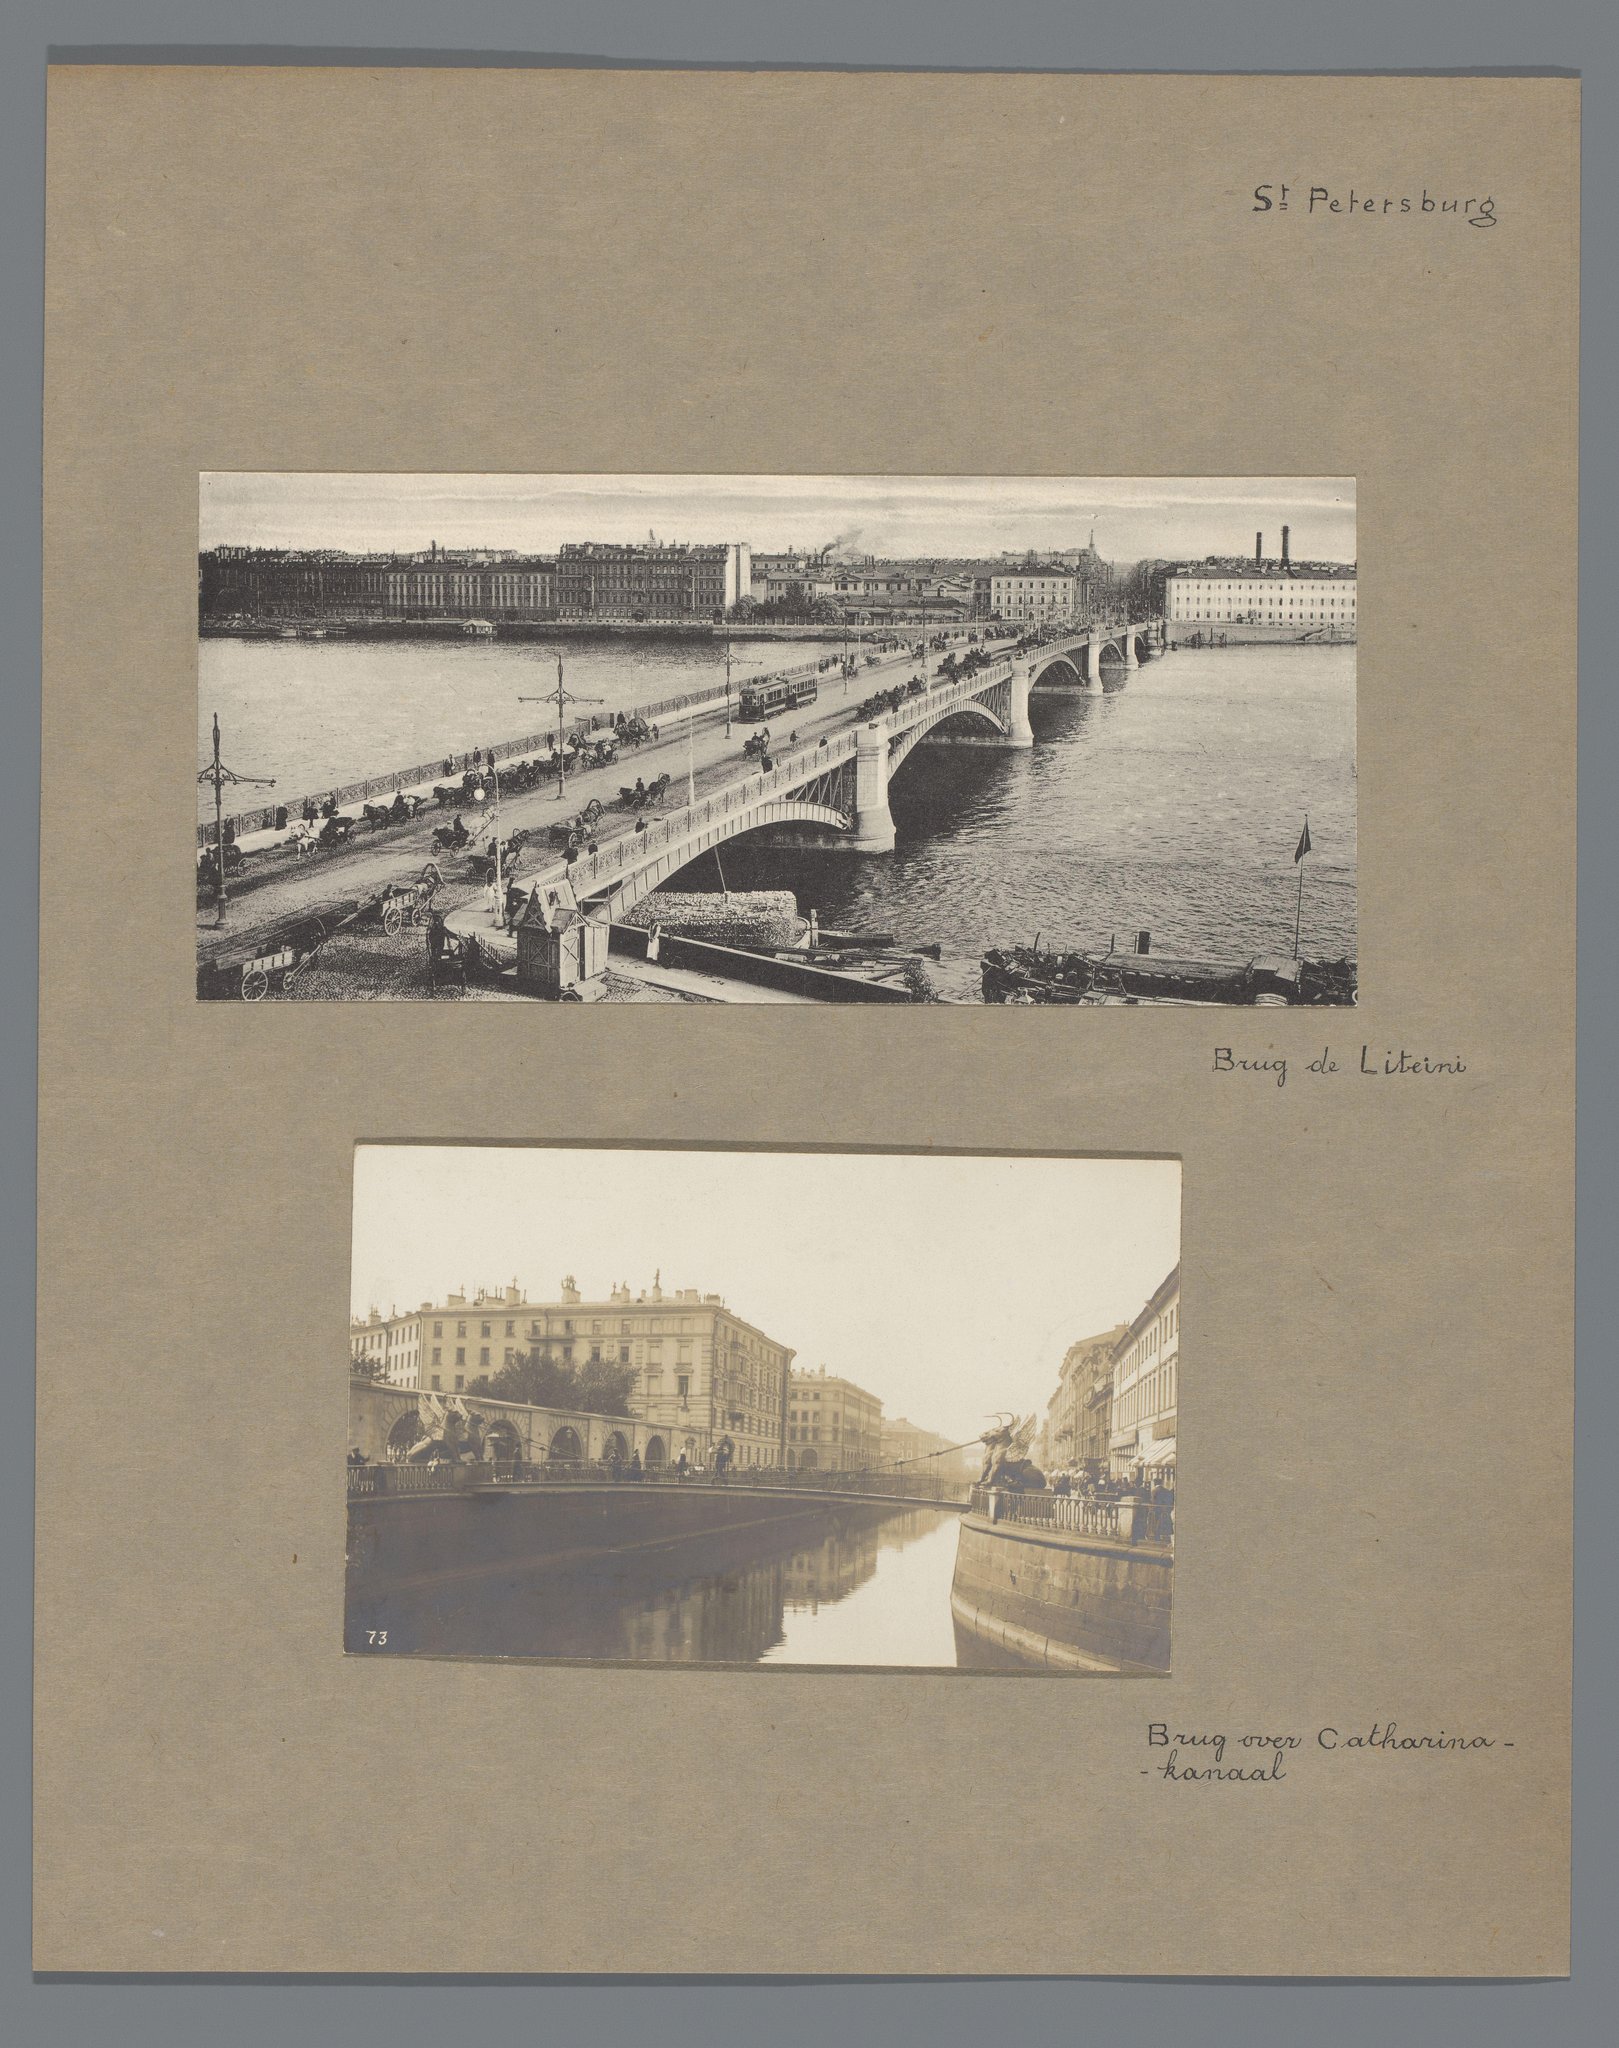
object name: photograph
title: St. Petersburg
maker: Anonymous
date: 1860-1925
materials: photographic support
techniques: photograph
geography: russia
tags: sint-petersburg